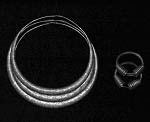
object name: jewelry set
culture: chinese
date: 1900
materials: silver